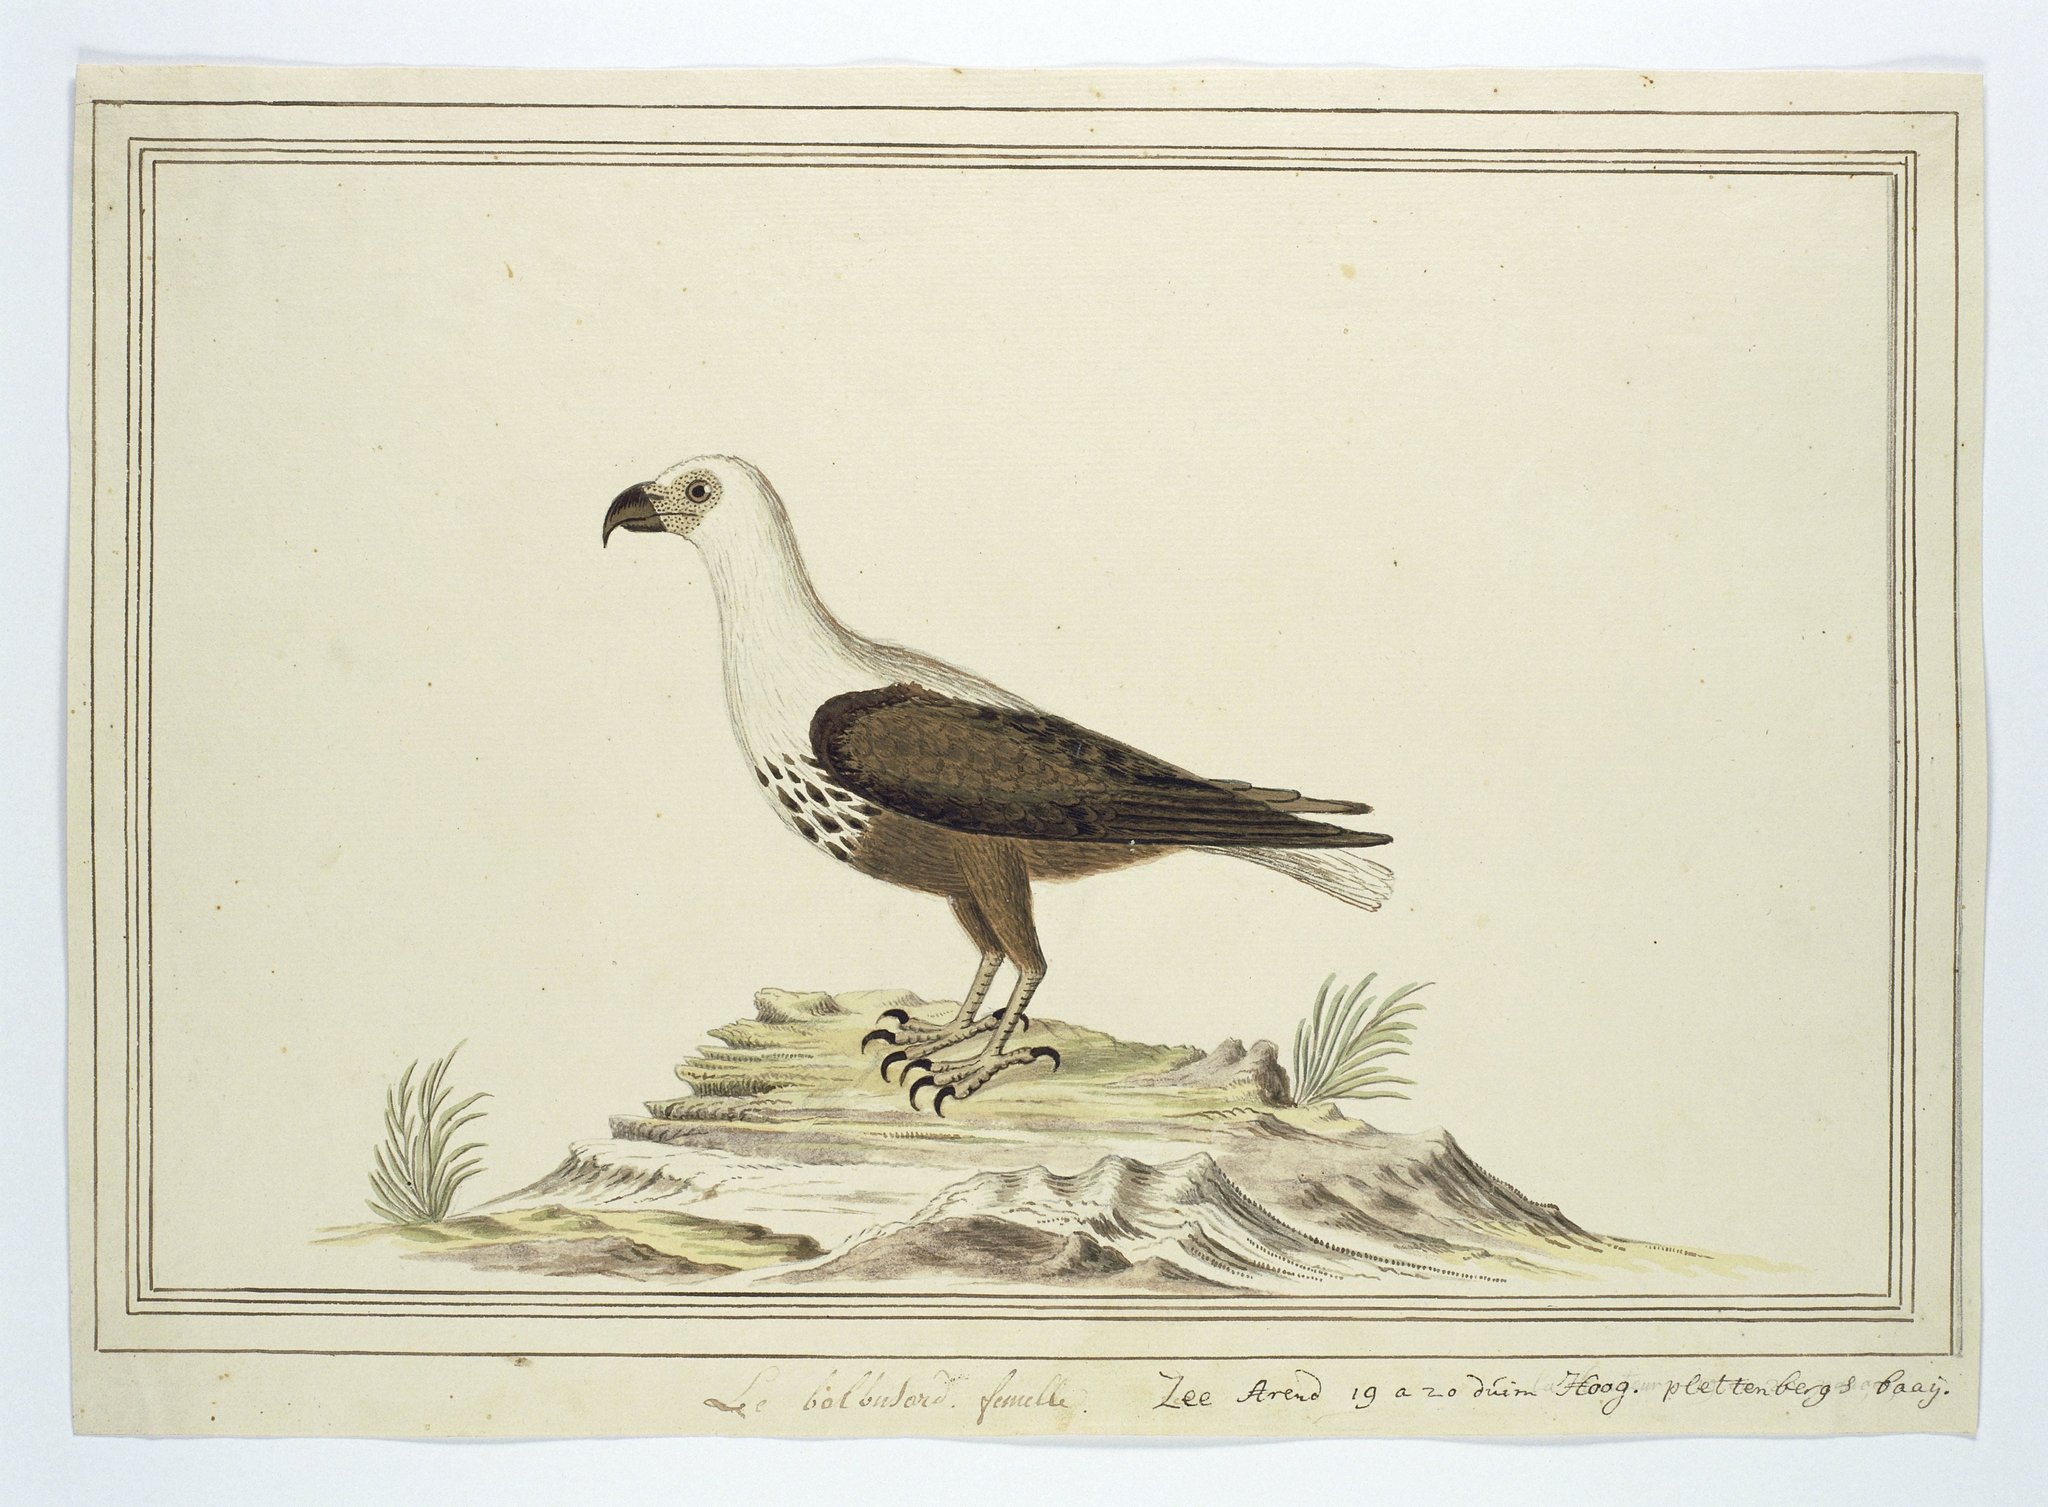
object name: album leaf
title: Haliaetus vocifer (African fish eagle)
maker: robert jacob gordon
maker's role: draughtsman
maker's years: 1743-1795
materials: chalk, ink, paper, pencil, watercolor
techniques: brush, pen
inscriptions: annotation: ‘Le bolbusard fmelle. Zee Arend 19 a 20 duim Hoog. plettenbergs baaij’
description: Vogelstudie: Visarend (Haliaaetus vocifer), door Gordon "zeearend" genoemd, waargenomen in Plettenbergbaai.